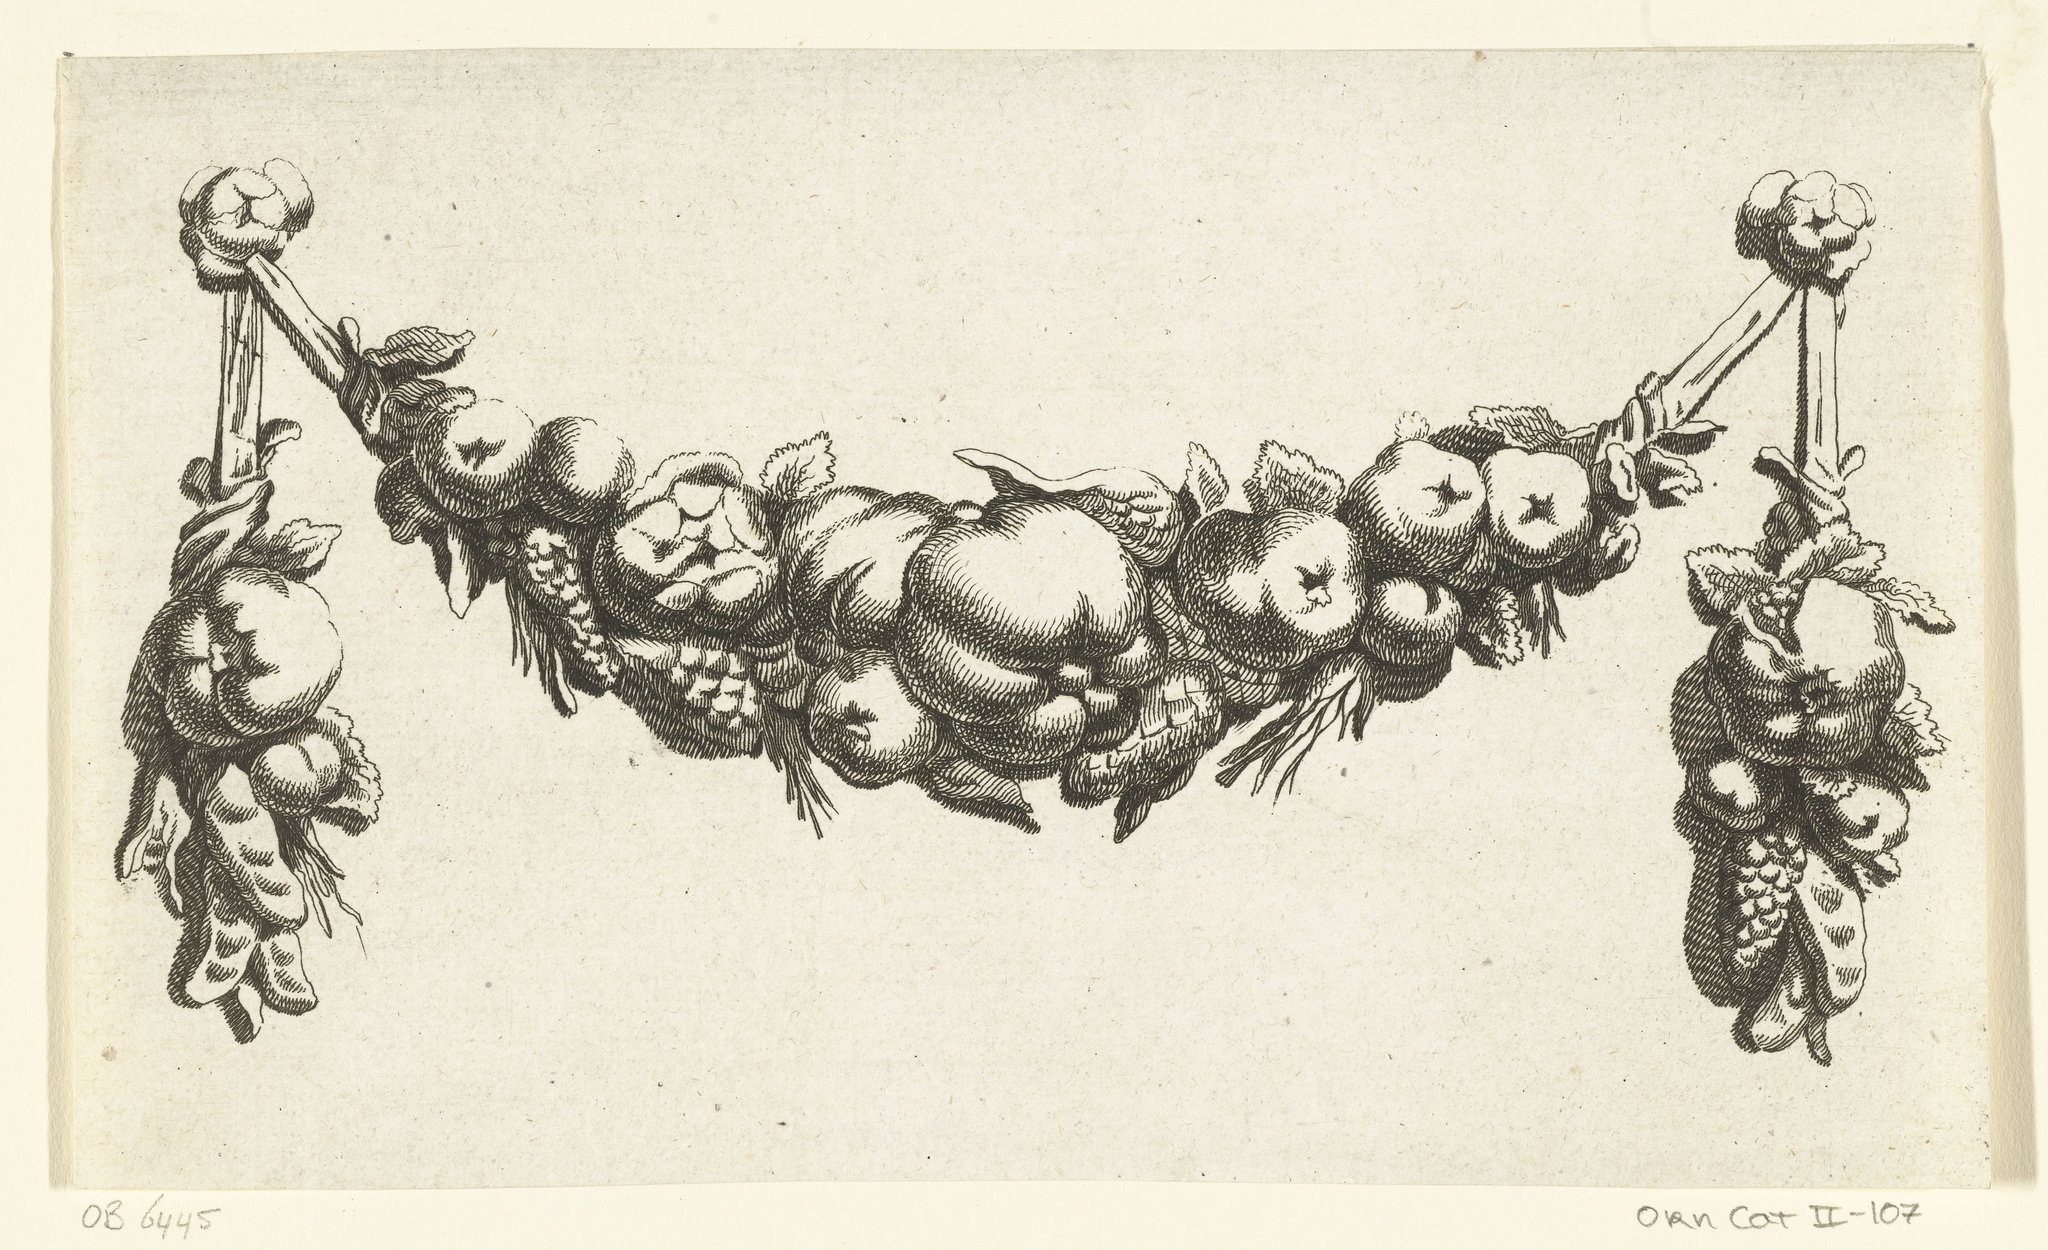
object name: ornament print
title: Festoen met een paprika in het midden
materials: paper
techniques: etching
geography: amsterdam